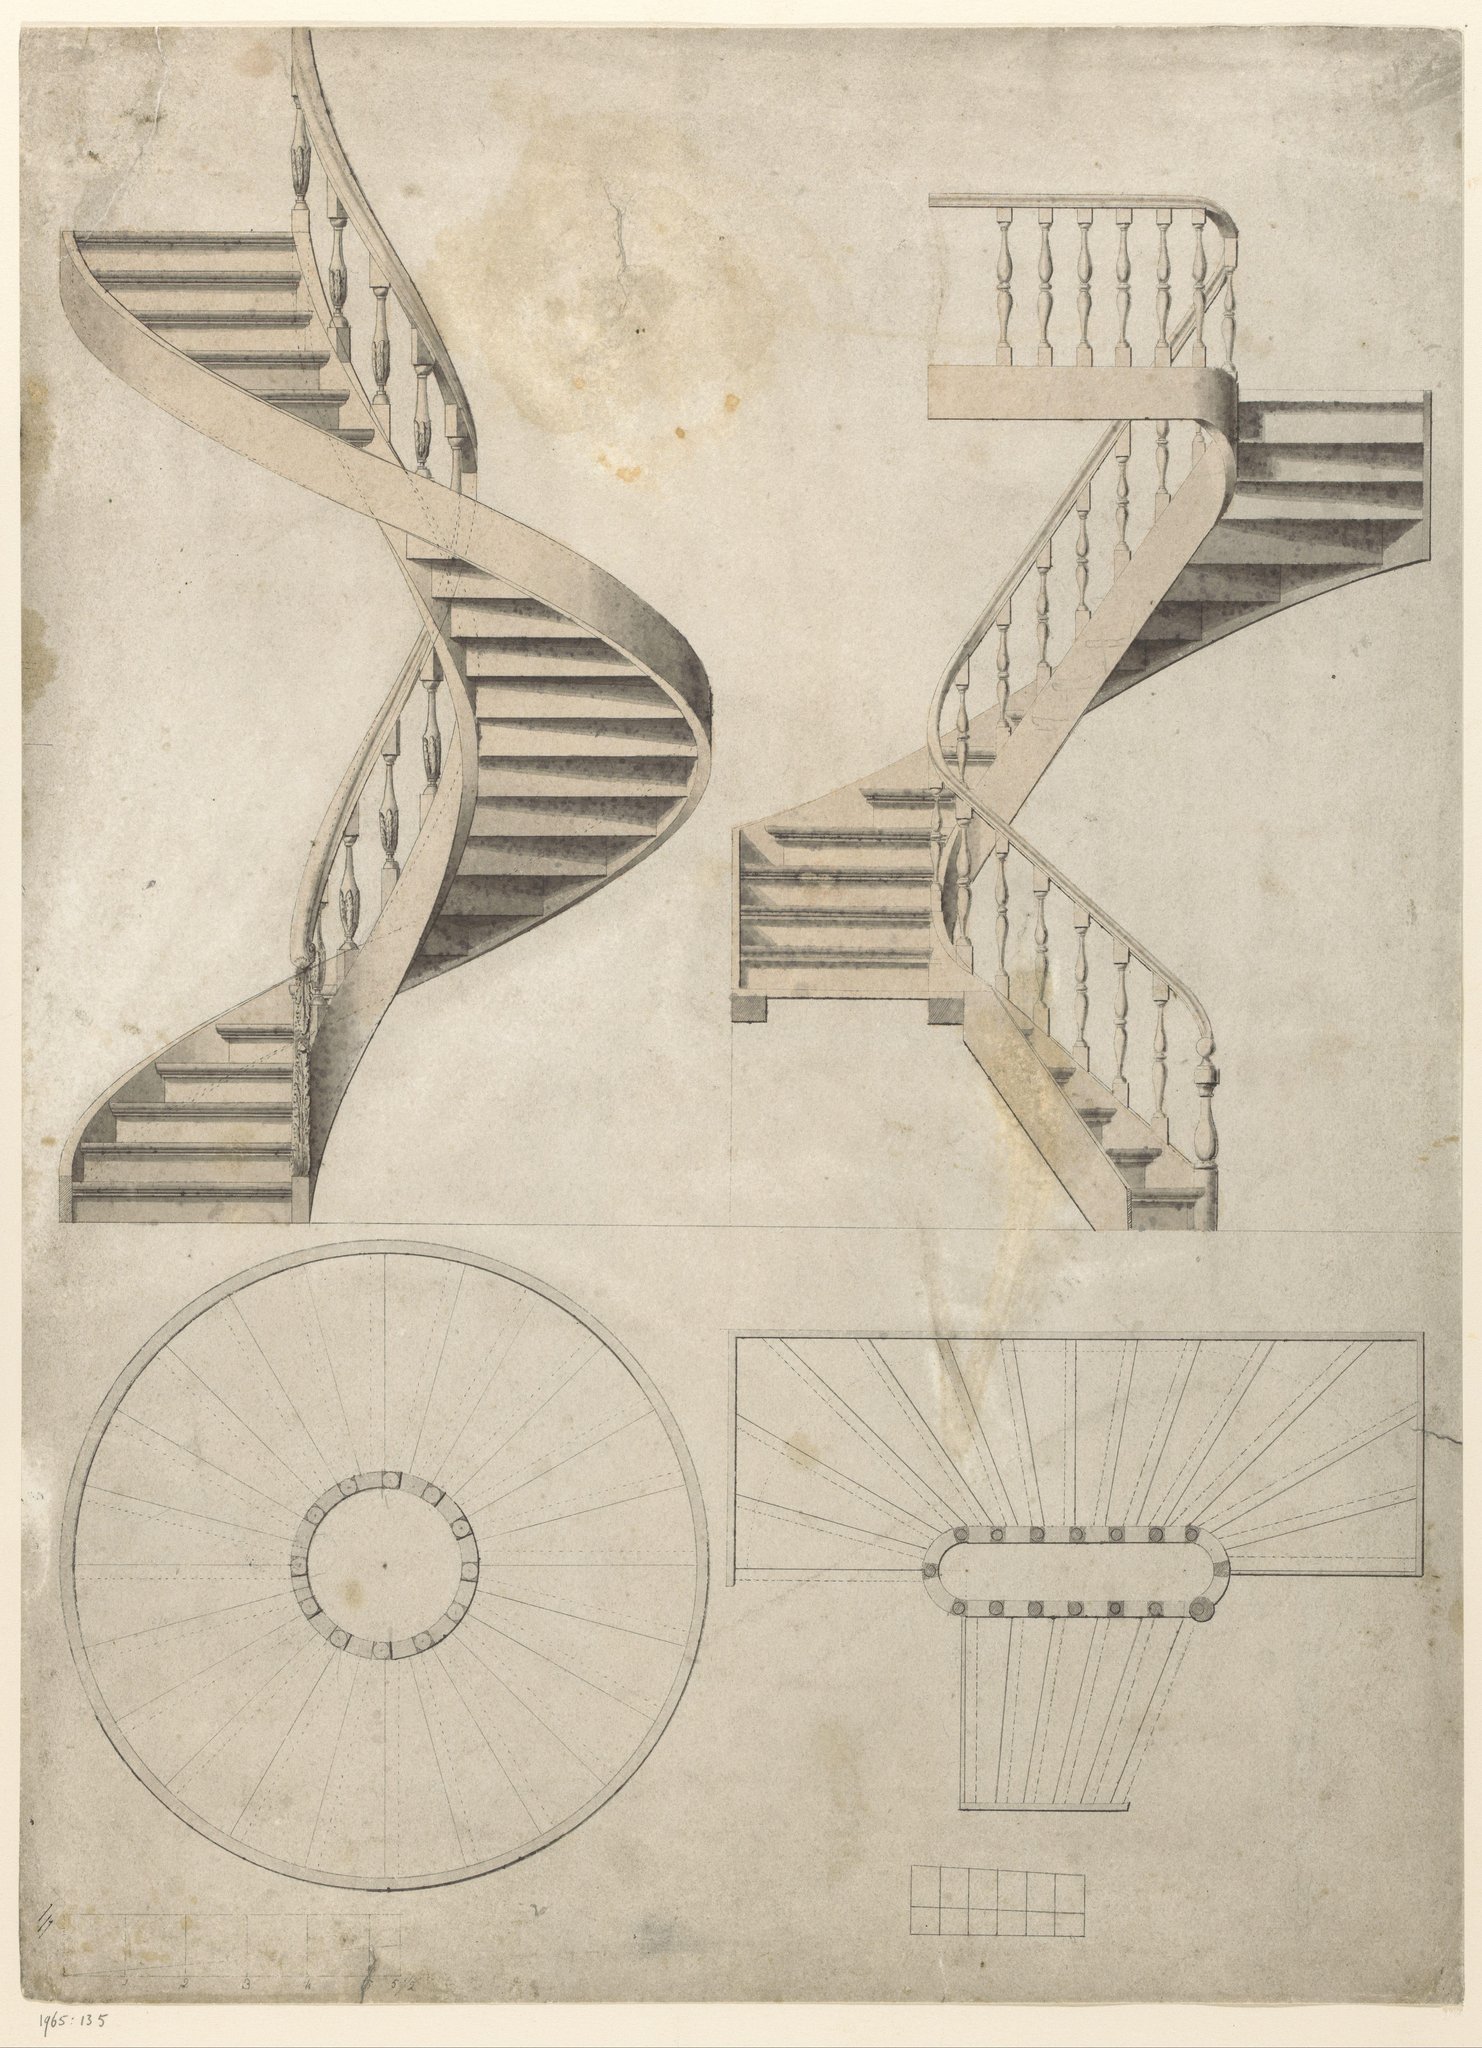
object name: drawing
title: Ontwerp voor twee wenteltrappen met plattegronden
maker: Anonymous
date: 1749-1849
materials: ink, paper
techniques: brush, pen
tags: interior ~ architectural design or model, staircase, plan ~ architecture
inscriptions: collector's mark: Lugt 2228